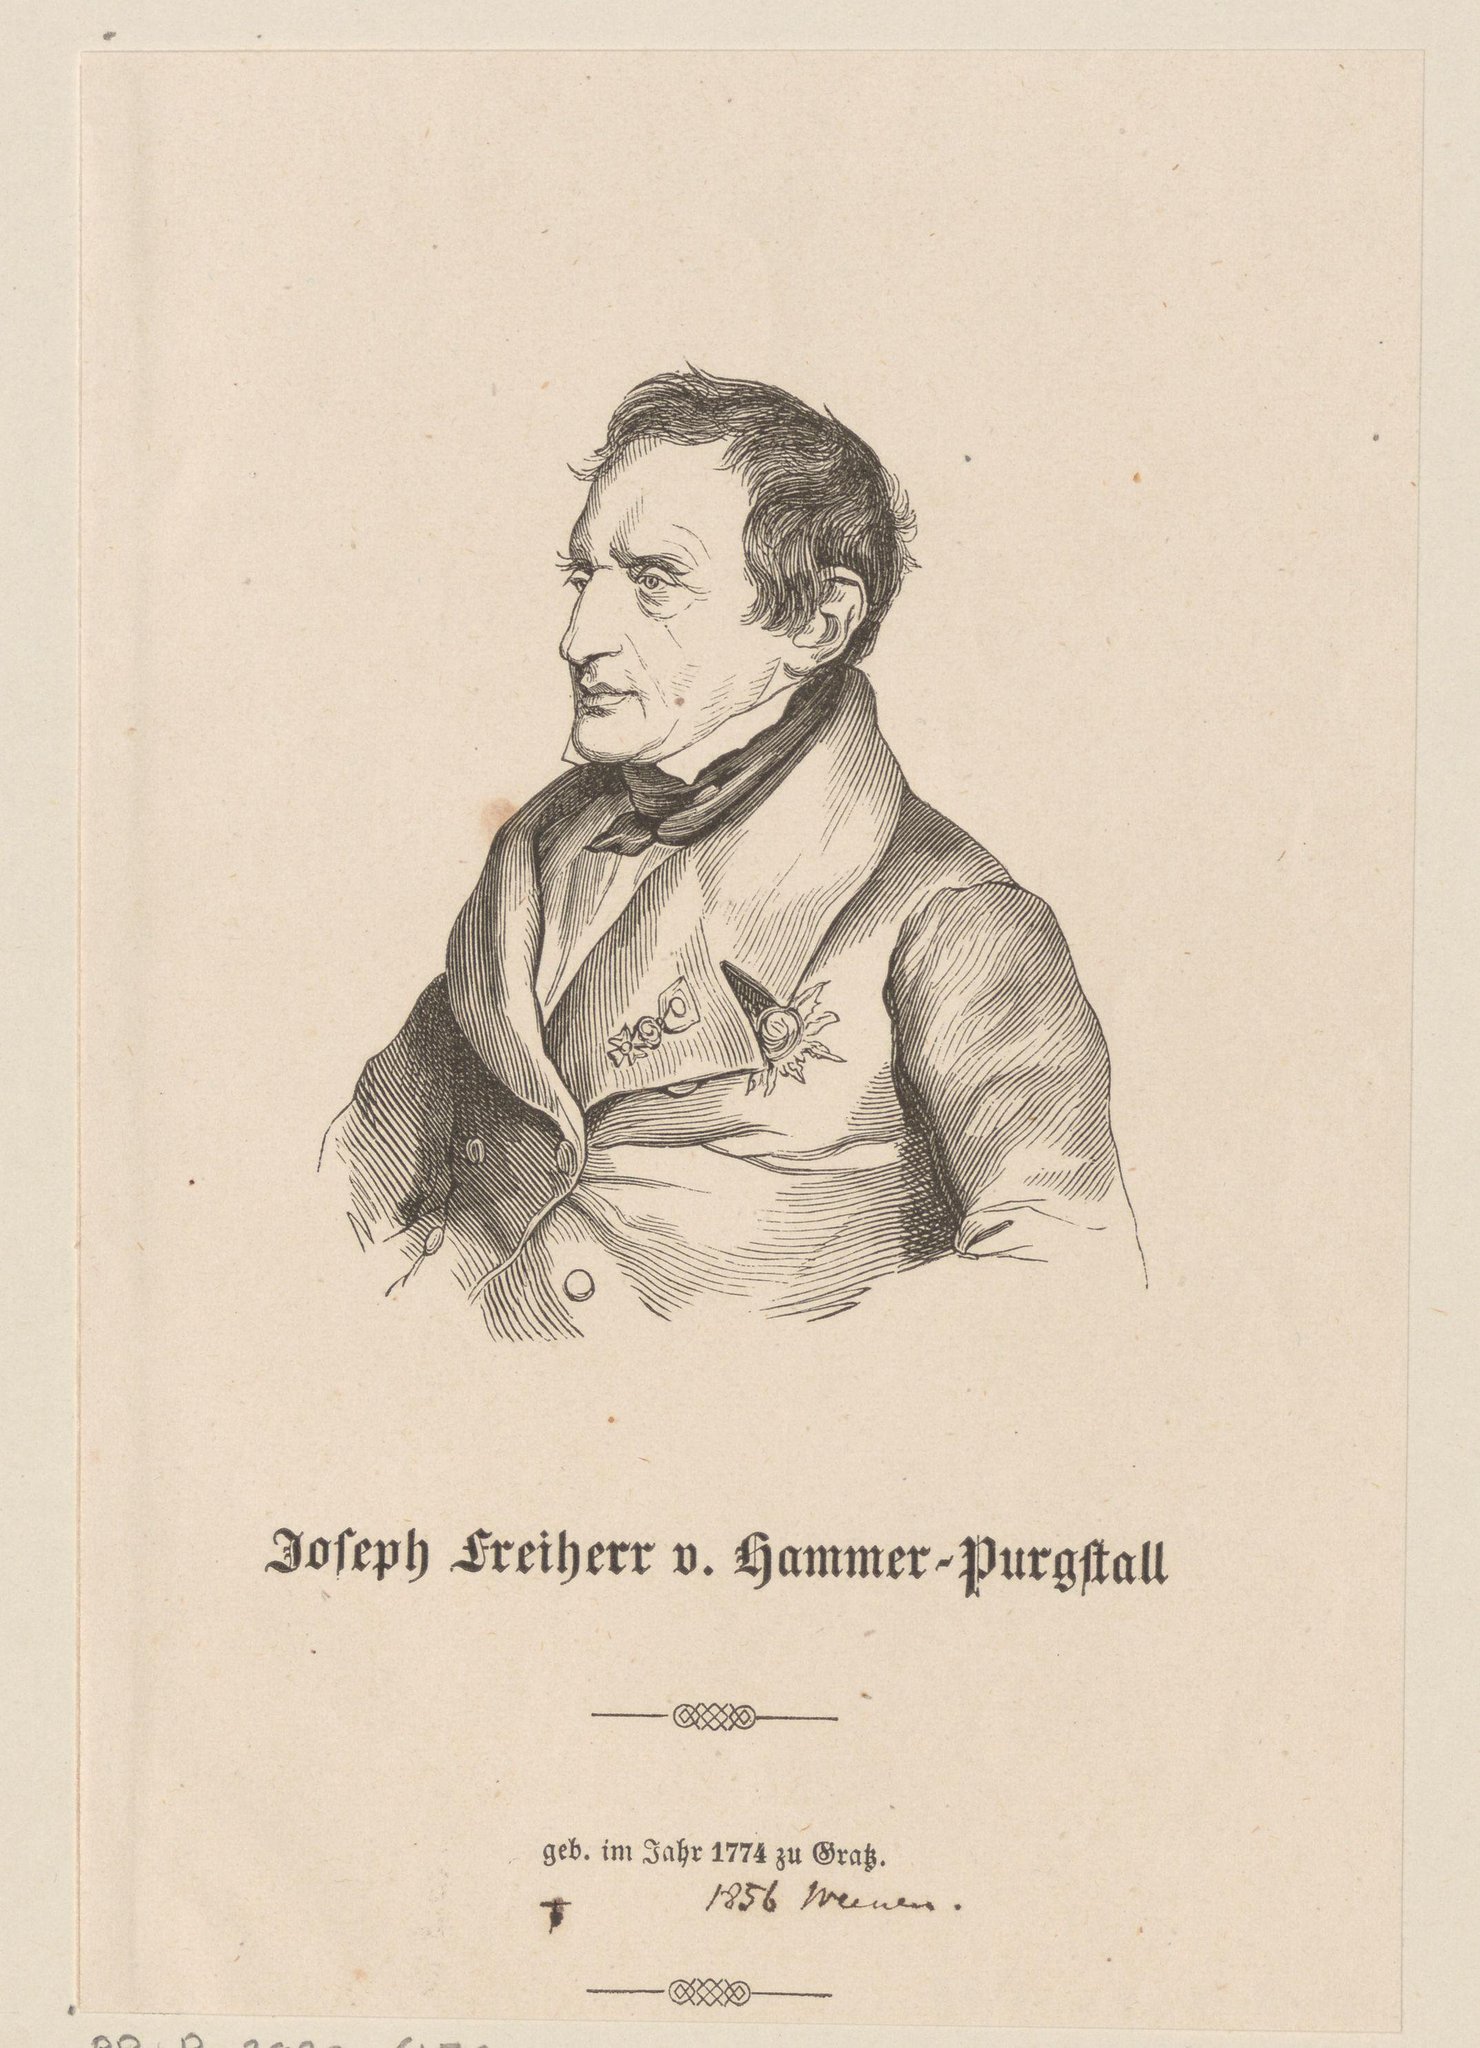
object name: print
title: Portret van Joseph von Hammer-Purgstall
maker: Anonymous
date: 1825-1874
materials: paper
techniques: letterpress printing, engraving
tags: vienna, historical persons